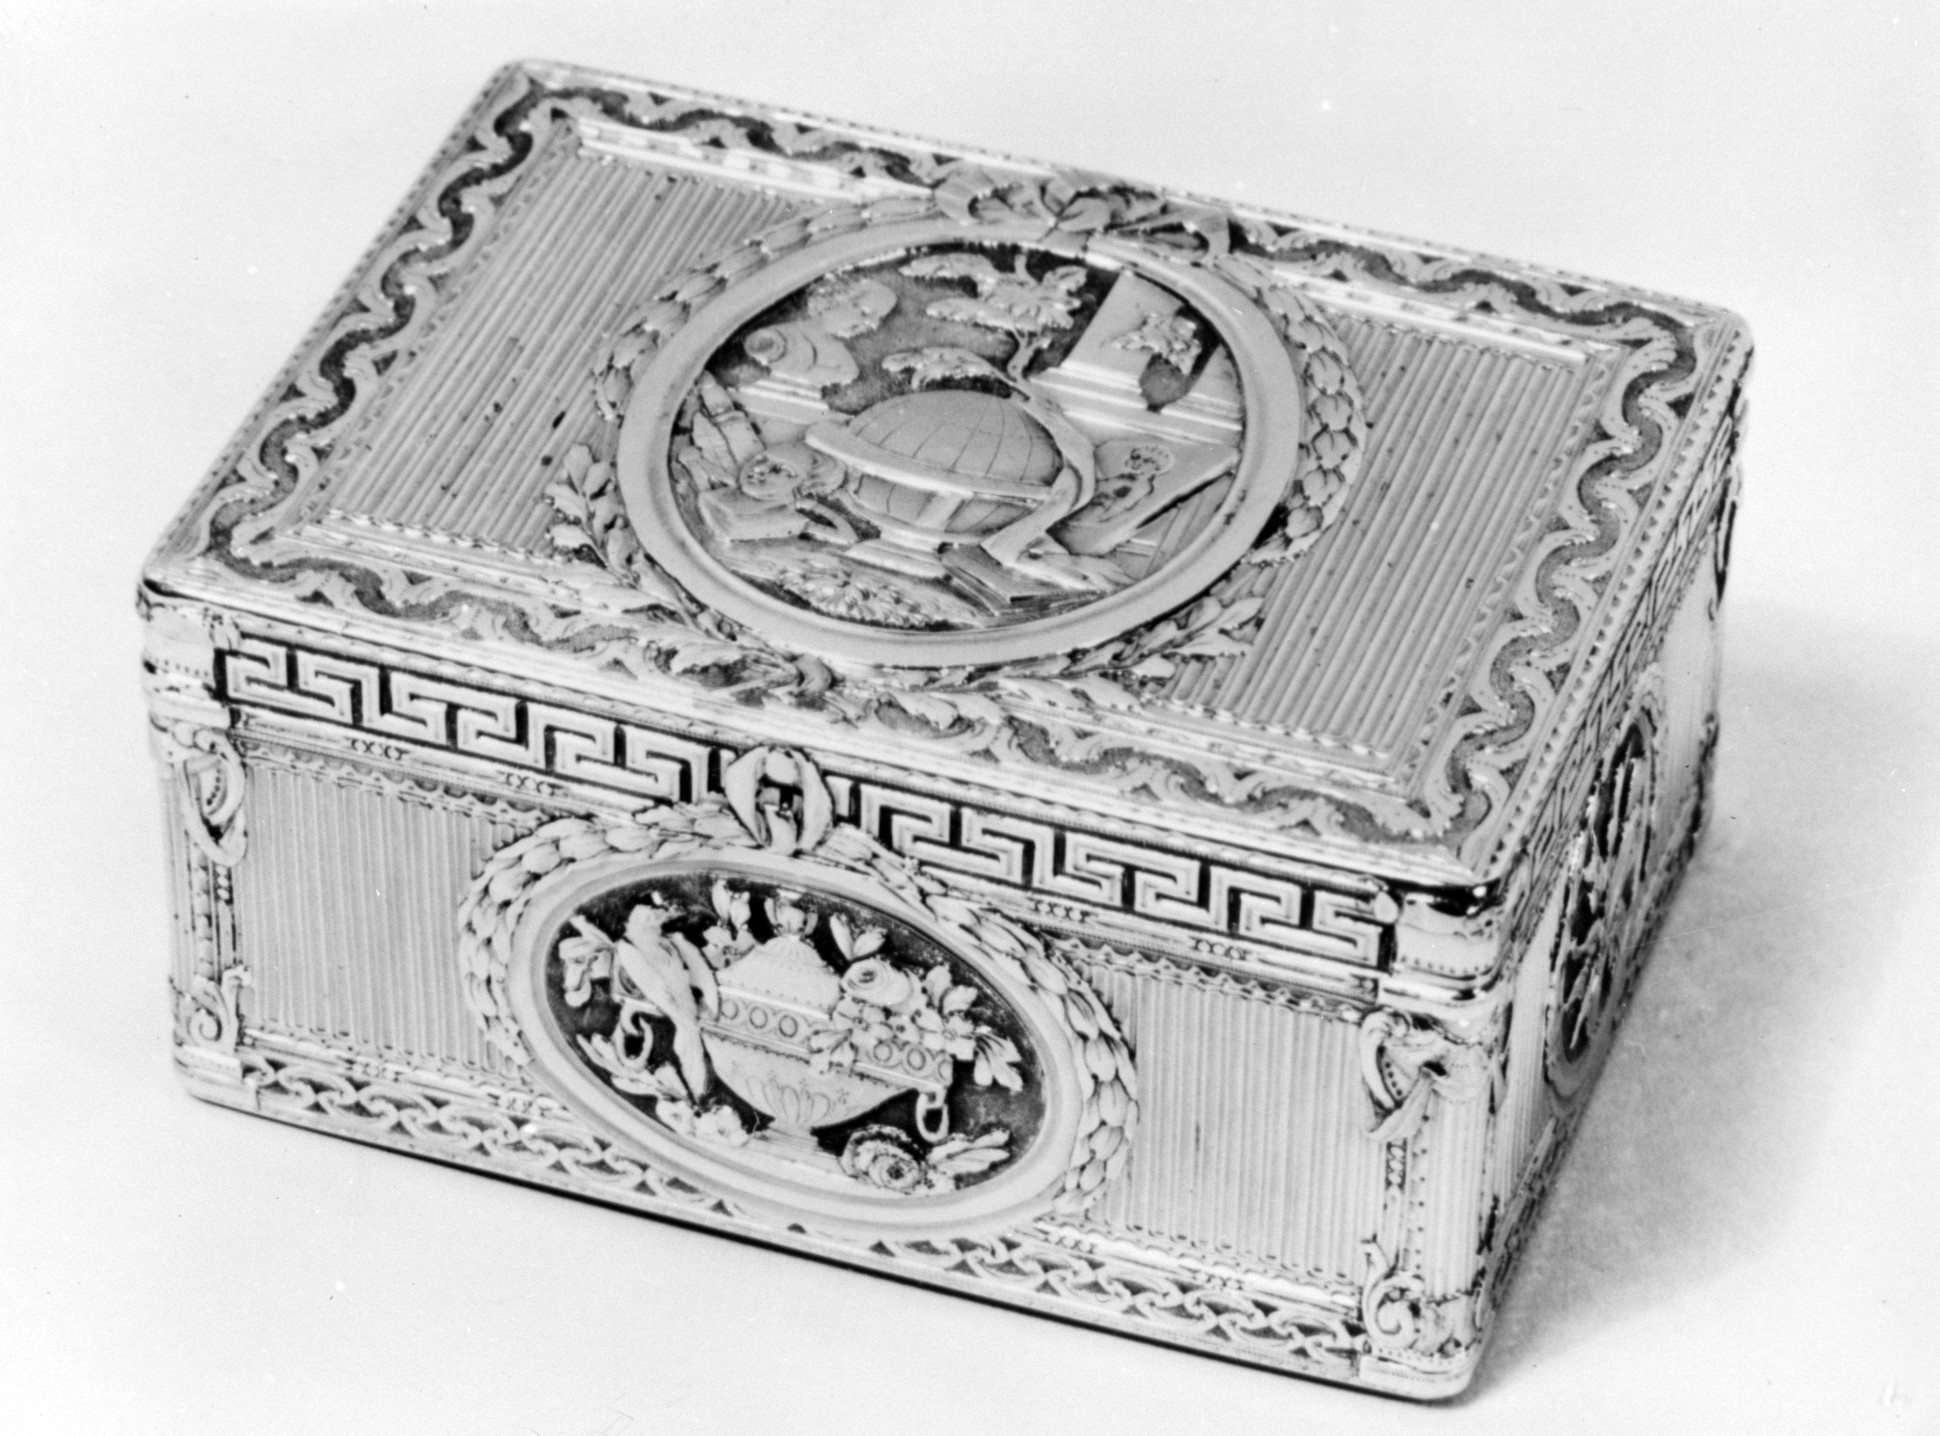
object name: snuffbox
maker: jean frémin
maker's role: maker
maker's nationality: french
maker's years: 1738-1786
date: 1763-1764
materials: gold